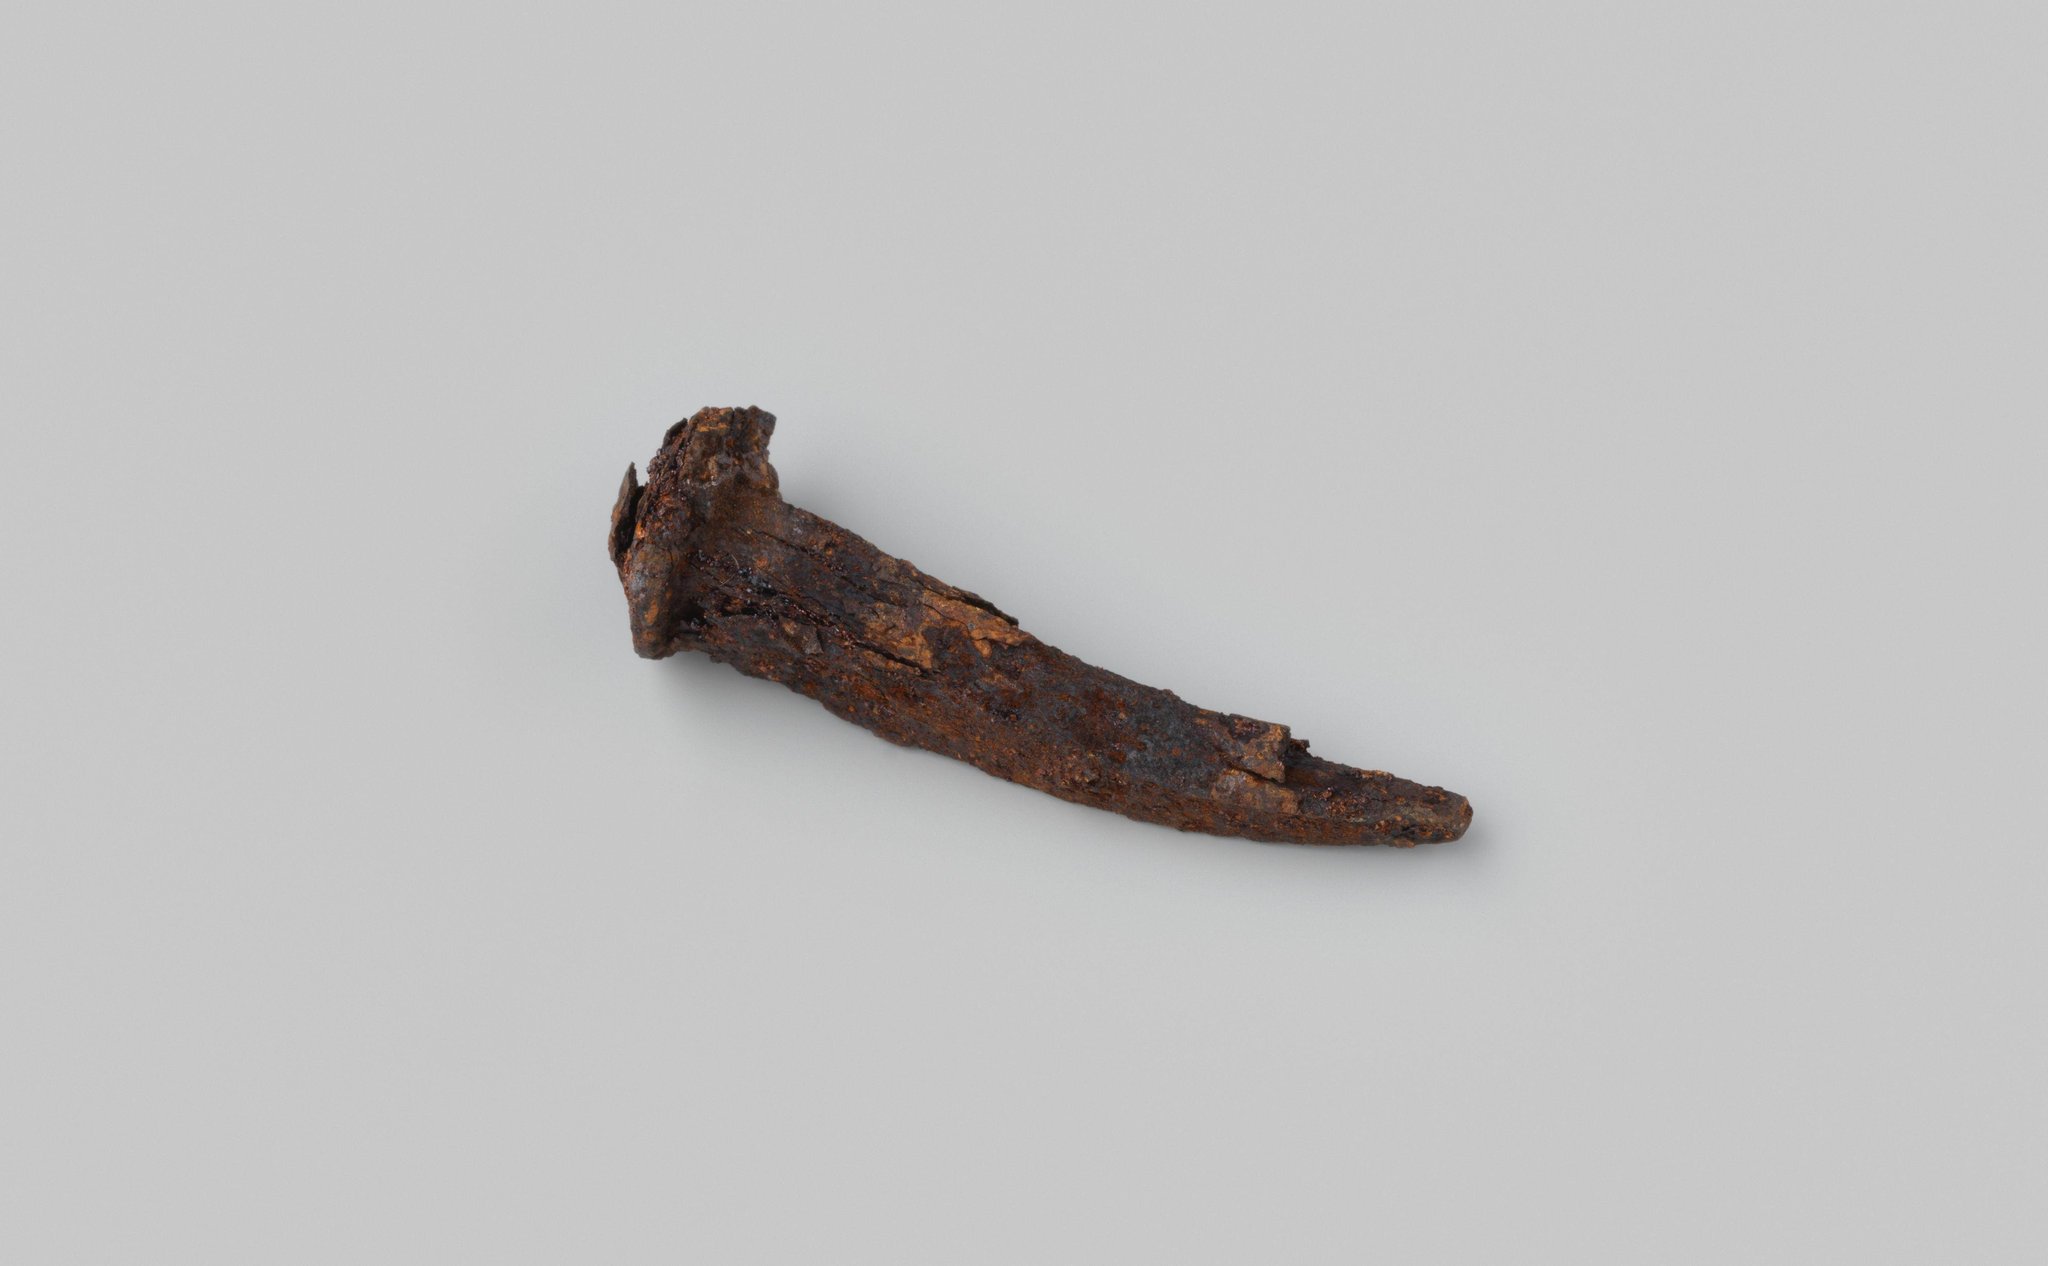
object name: nagel, spijker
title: Spijker afkomstig uit het wrak van de Oost-Indiëvaarder Hollandia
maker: Anonymous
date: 1700-1743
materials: iron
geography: netherlands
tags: verenigde oostindische compagnie, hollandia (schip)